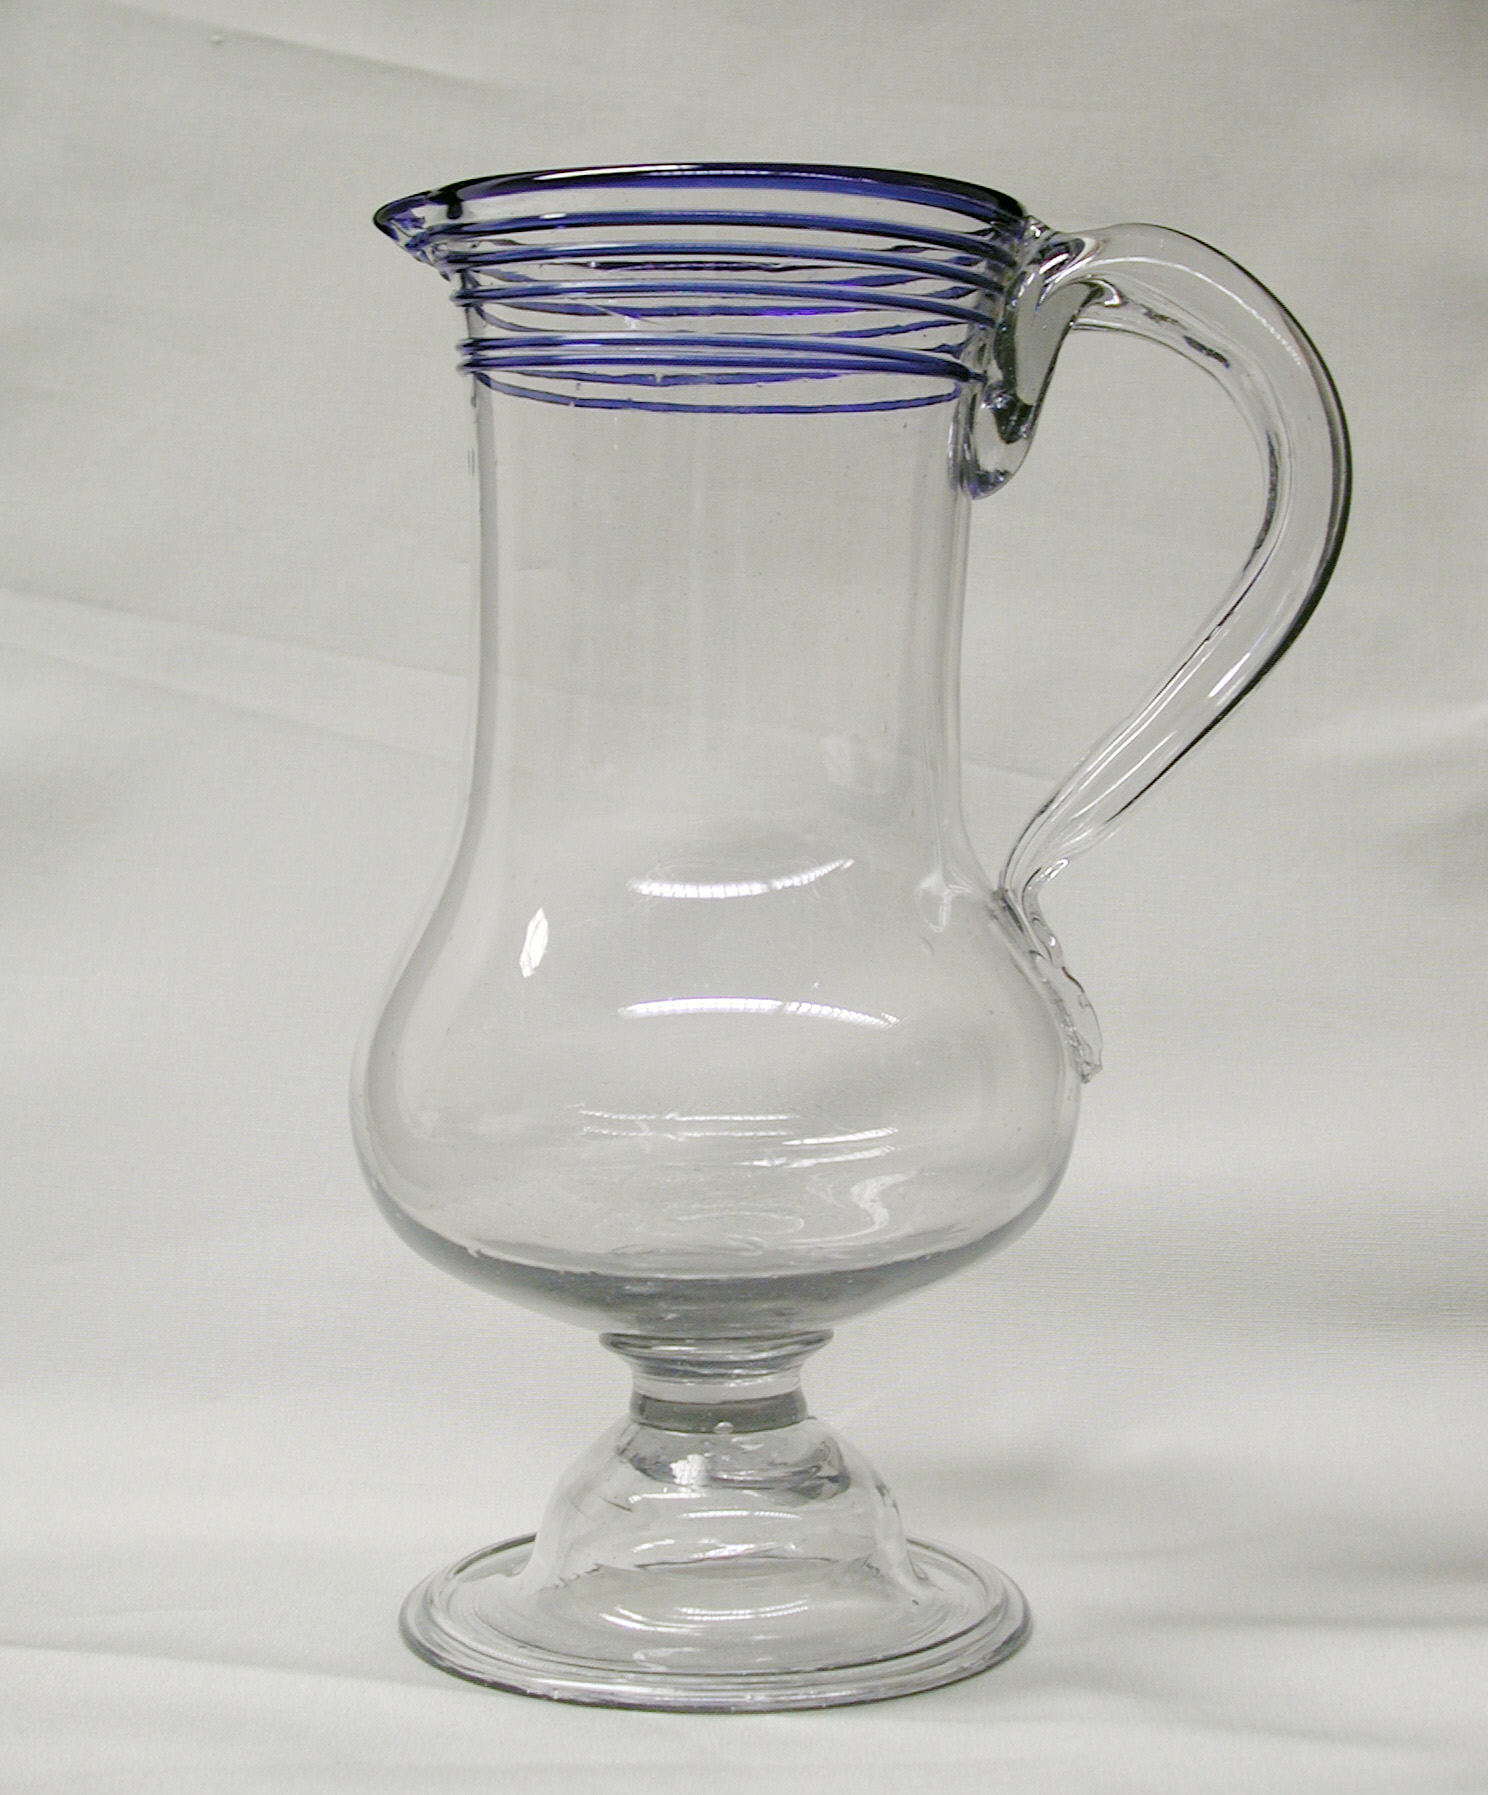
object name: jug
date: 1701-1750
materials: glass